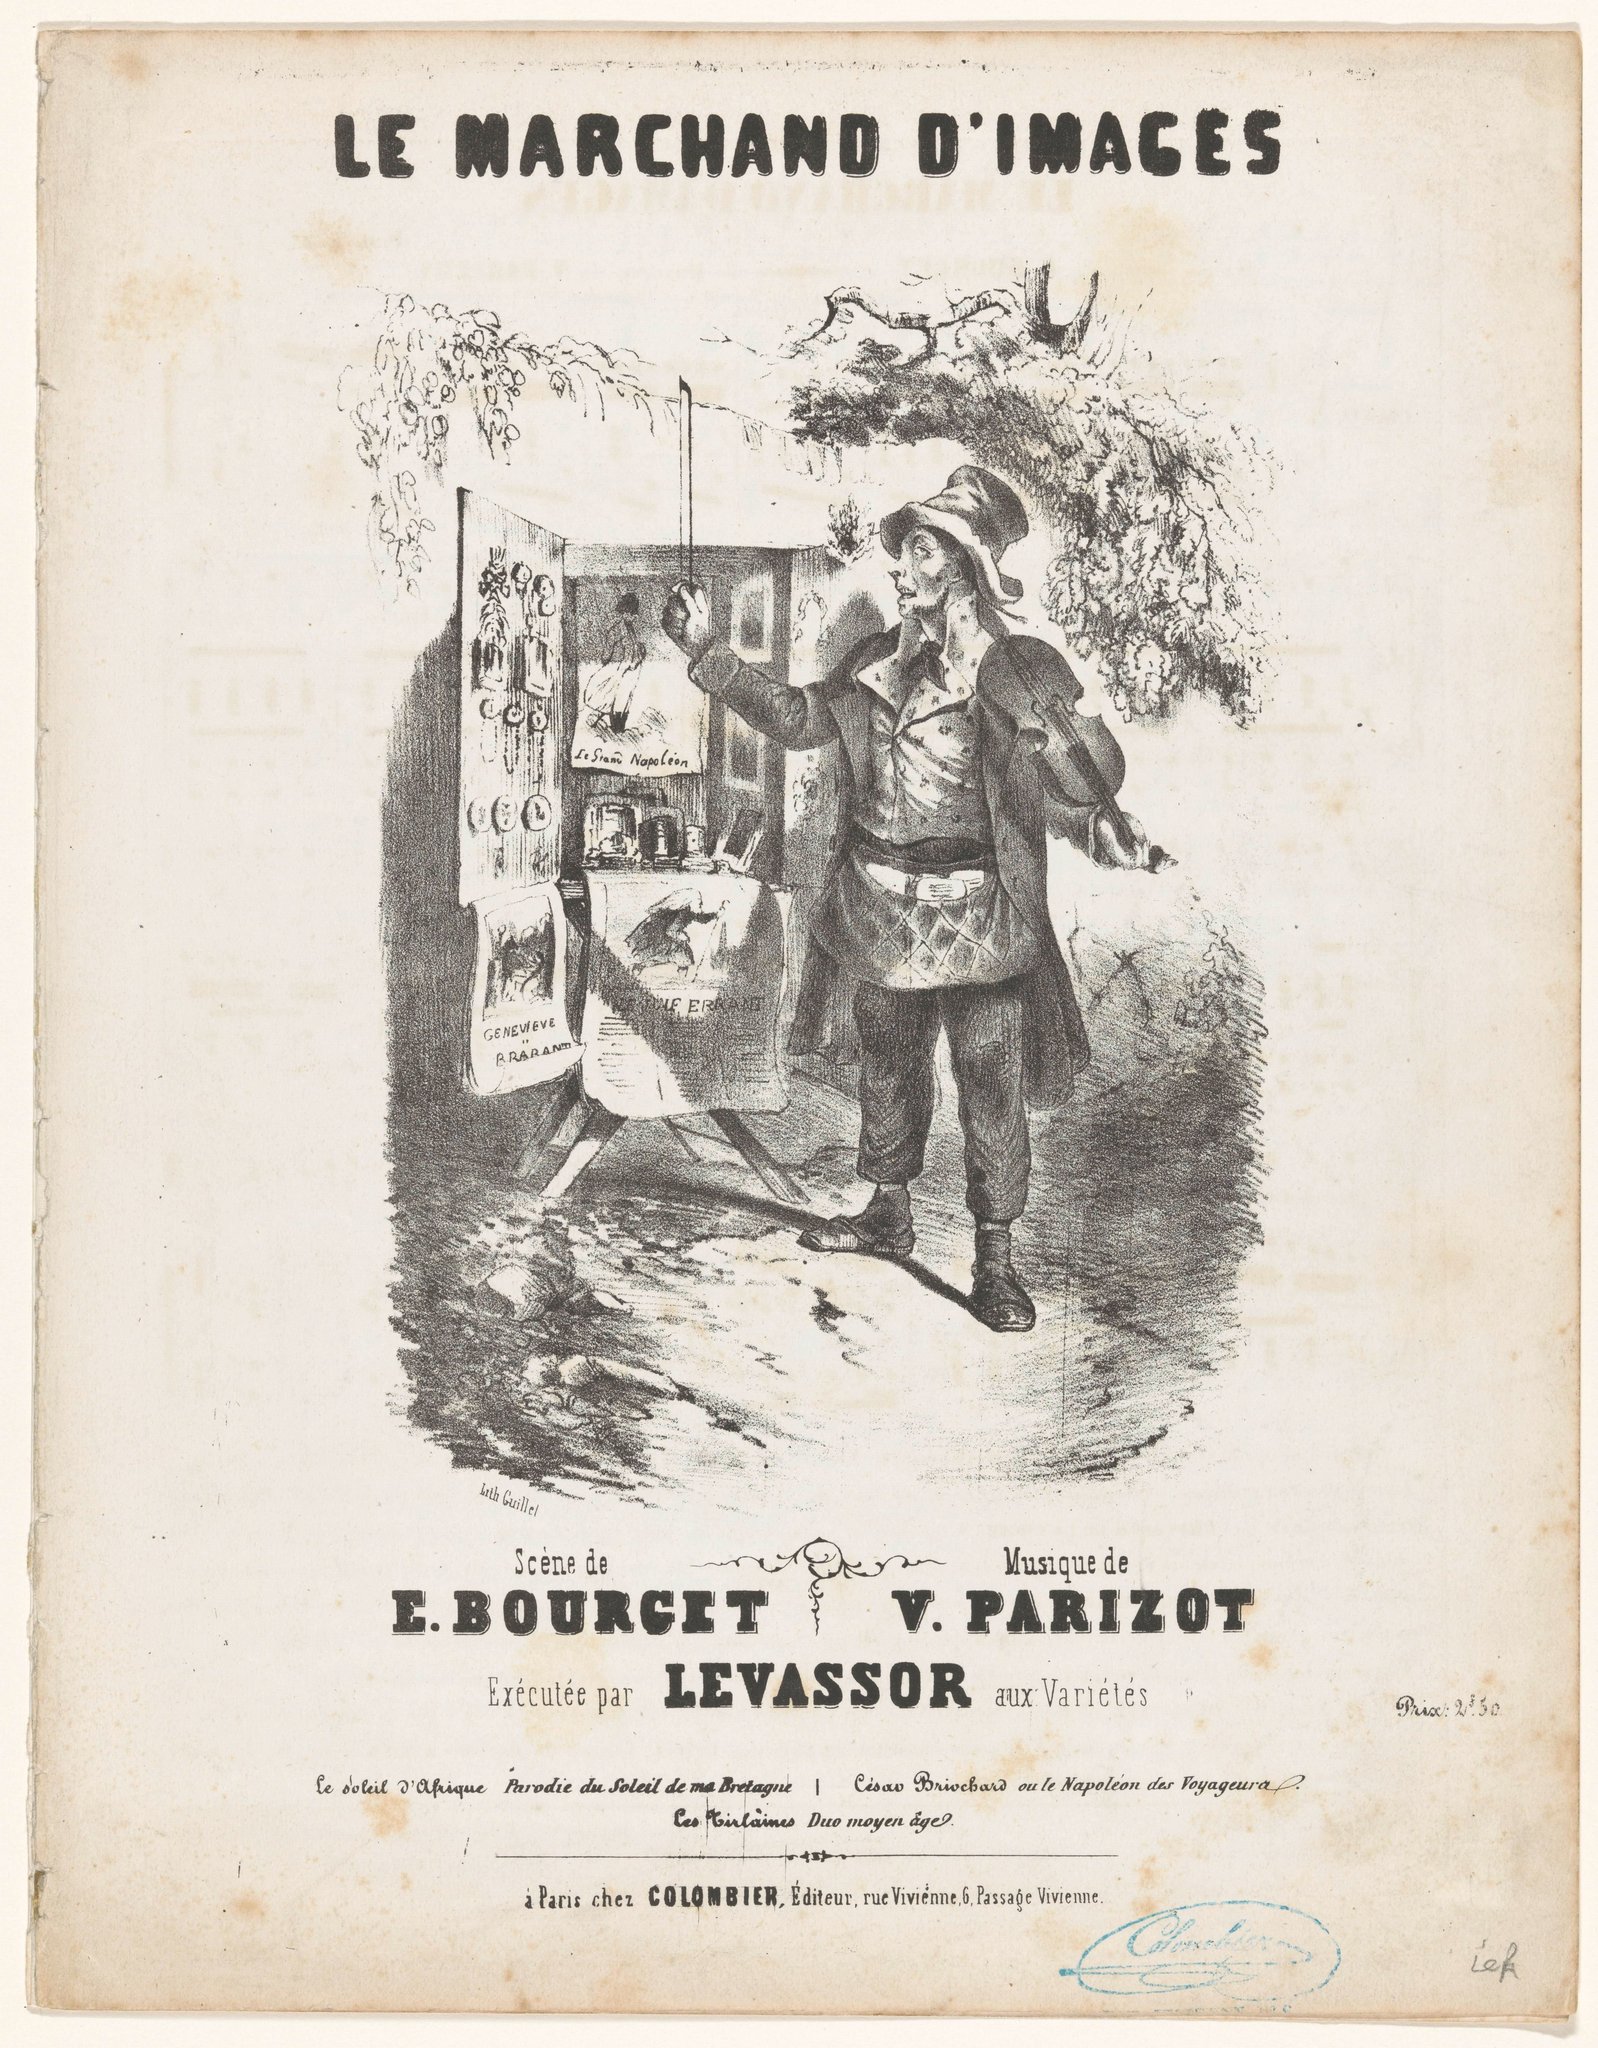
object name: book cover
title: Prenthandelaar met viool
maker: Anonymous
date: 1842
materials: paper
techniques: lithograph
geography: paris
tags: viol, rebec (violin-like instruments) - cc - out of doors, street-trader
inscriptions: collector's mark: Lugt 2228, stamp: ‘Colombier’, collector's mark: Lugt 4780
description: Een prenthandelaar staat met zijn viool in de hand voor een opengeklapte kist op schragen. De binnenkant bevat prenten en andere snuisterijen. Met bladmuziek op verso.